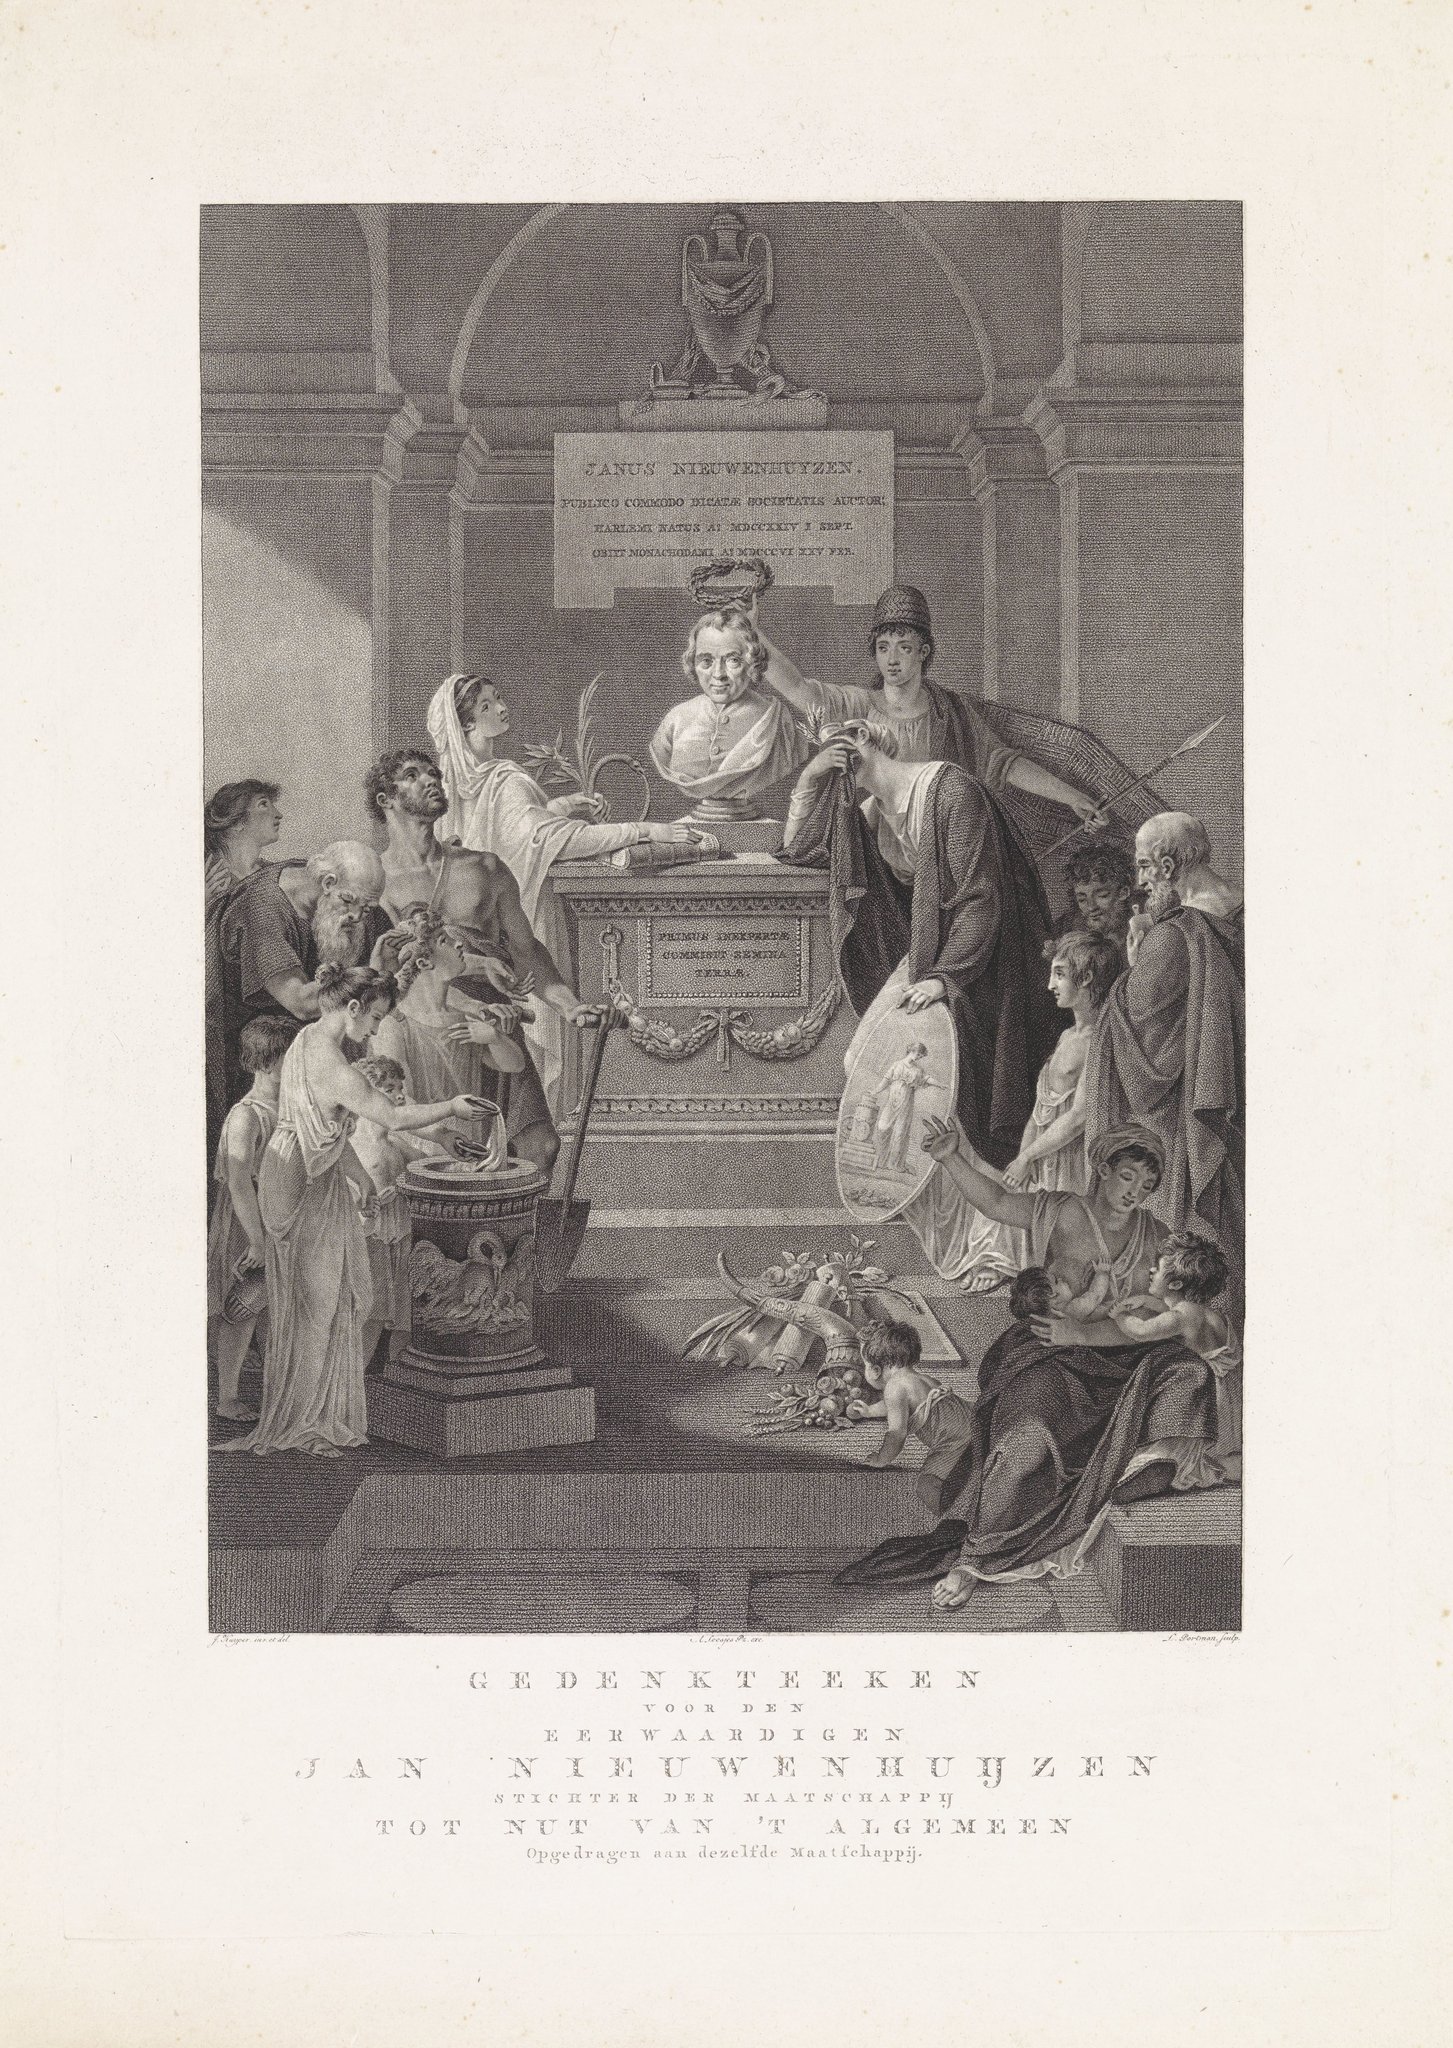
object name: print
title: Allegorische voorstelling met gedenksteen voor Jan Nieuwenhuyzen, overleden in 1806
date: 1806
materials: paper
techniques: etching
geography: amsterdam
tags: haarlem, amsterdam, jan nieuwenhuyzen, 'cornucopia', horn of plenty, charity, 'caritas'; 'carità' (ripa) ~ one of the three theological virtues, offering; 'offerta overo oblatione' (ripa) (+ allegorical scene, i.e. two or more personifications involved in an action), symbols, allegories of peace, 'pax'; 'pace' (ripa), serpent ouroboros, urn, crowning with laurel, love towards god; 'amore verso iddio' (ripa), grave, tomb and other grave-forms and grave-markers, youth, adolescence, 'iuventus'; 'adolescenza', 'gioventù' (ripa), the bible as a book, symbols of particular nations, states, districts, etc.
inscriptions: collector's mark: Lugt 2228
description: Gedenksteen voor Jan Nieuwenhuyzen, overleden 25 februari 1806. Op een altaar in een nis staat de buste van Jan Nieuwenhuyzen, stichter van de Maatschappij Tot Nut van 't Algemeen. Daarboven een kader met de naam, geboorte- en sterfdatum van Nieuwenhuyzen. Op het altaar een motto in het Latijn (Hij plantte daar niets stond). De buste wordt gelauwerd door de Hollandse Maagd. Voor haar de personificatie van de Maatschappij die haar betraande gezicht bedekt en leunt op het altaar en haar schild. Aan de andere kant van het altaar kijkt de Godsvrucht op naar de buste. Haar hand rust op een bijbel (Zaligheid), in de andere houdt zij de slang die in zijn eigen staart bijt (Eeuwigheid) en een palmtak (Vrede). Een jonge vrouw, die de Jeugd symboliseert, offert op het altaar van Dankbaarheid. Op de voorgrond zit Liefde, die wijst op de buste van de stichter. Een van de kinderen reikt naar de vruchten uit de hoorn des overvloeds (het kind plukt reeds de vruchten van de stichting van de Maatschappij).